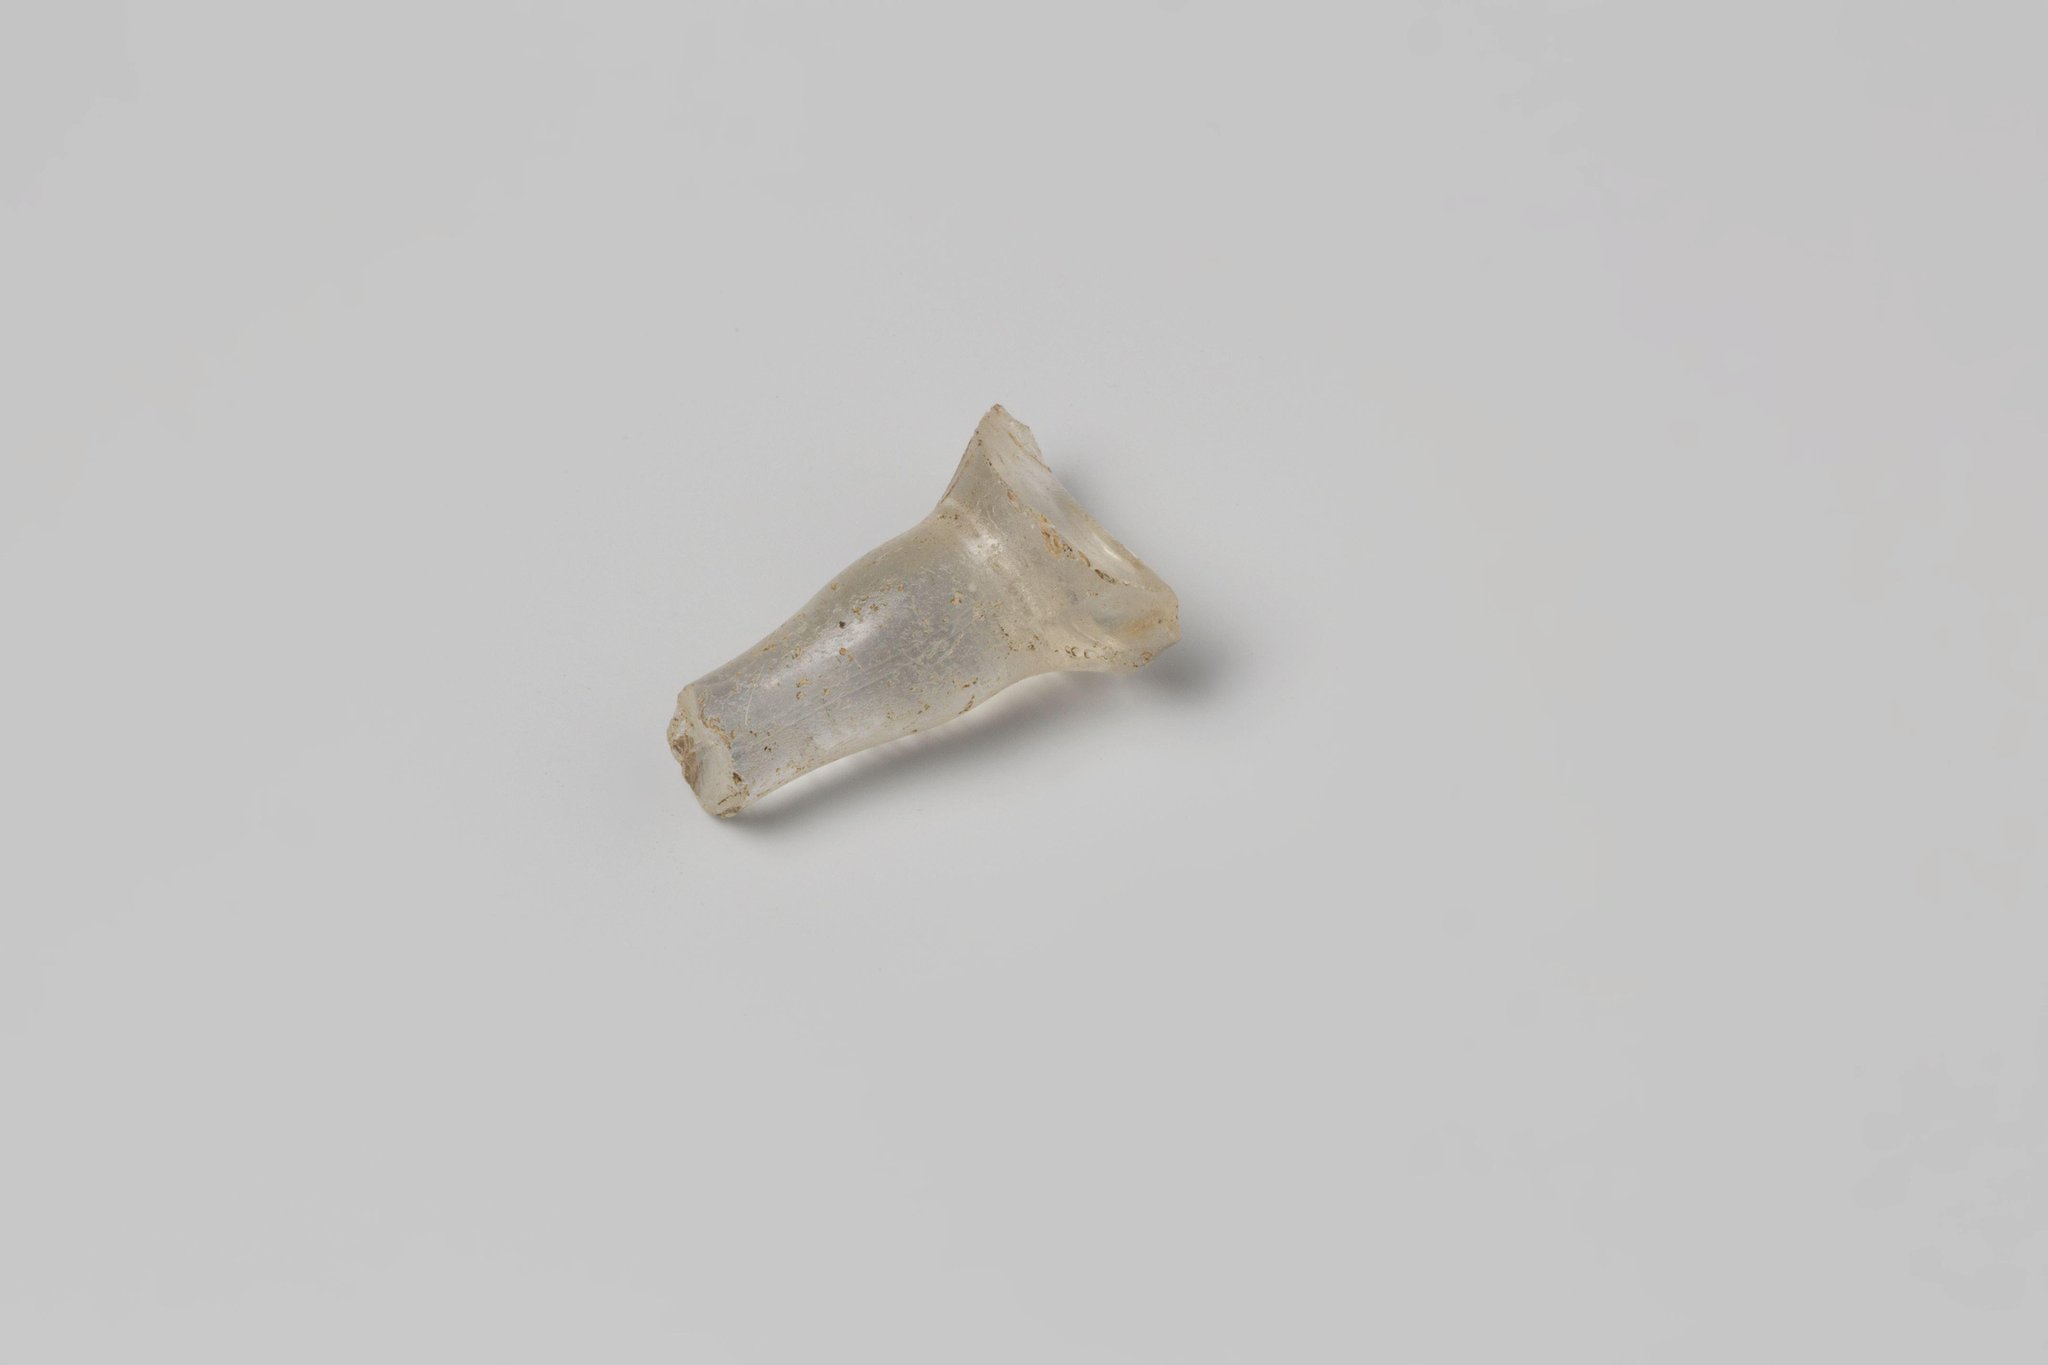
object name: drinking glass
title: Fragment rechte steel van glas uit het wrak van de Oost-Indiëvaarder Hollandia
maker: Anonymous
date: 1700-1743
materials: glass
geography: netherlands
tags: verenigde oostindische compagnie, hollandia (schip), annet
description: Glass, stem glass, stems, plain; fragm of lower end, solid, tapering, cf. NG 1980-27H1283.